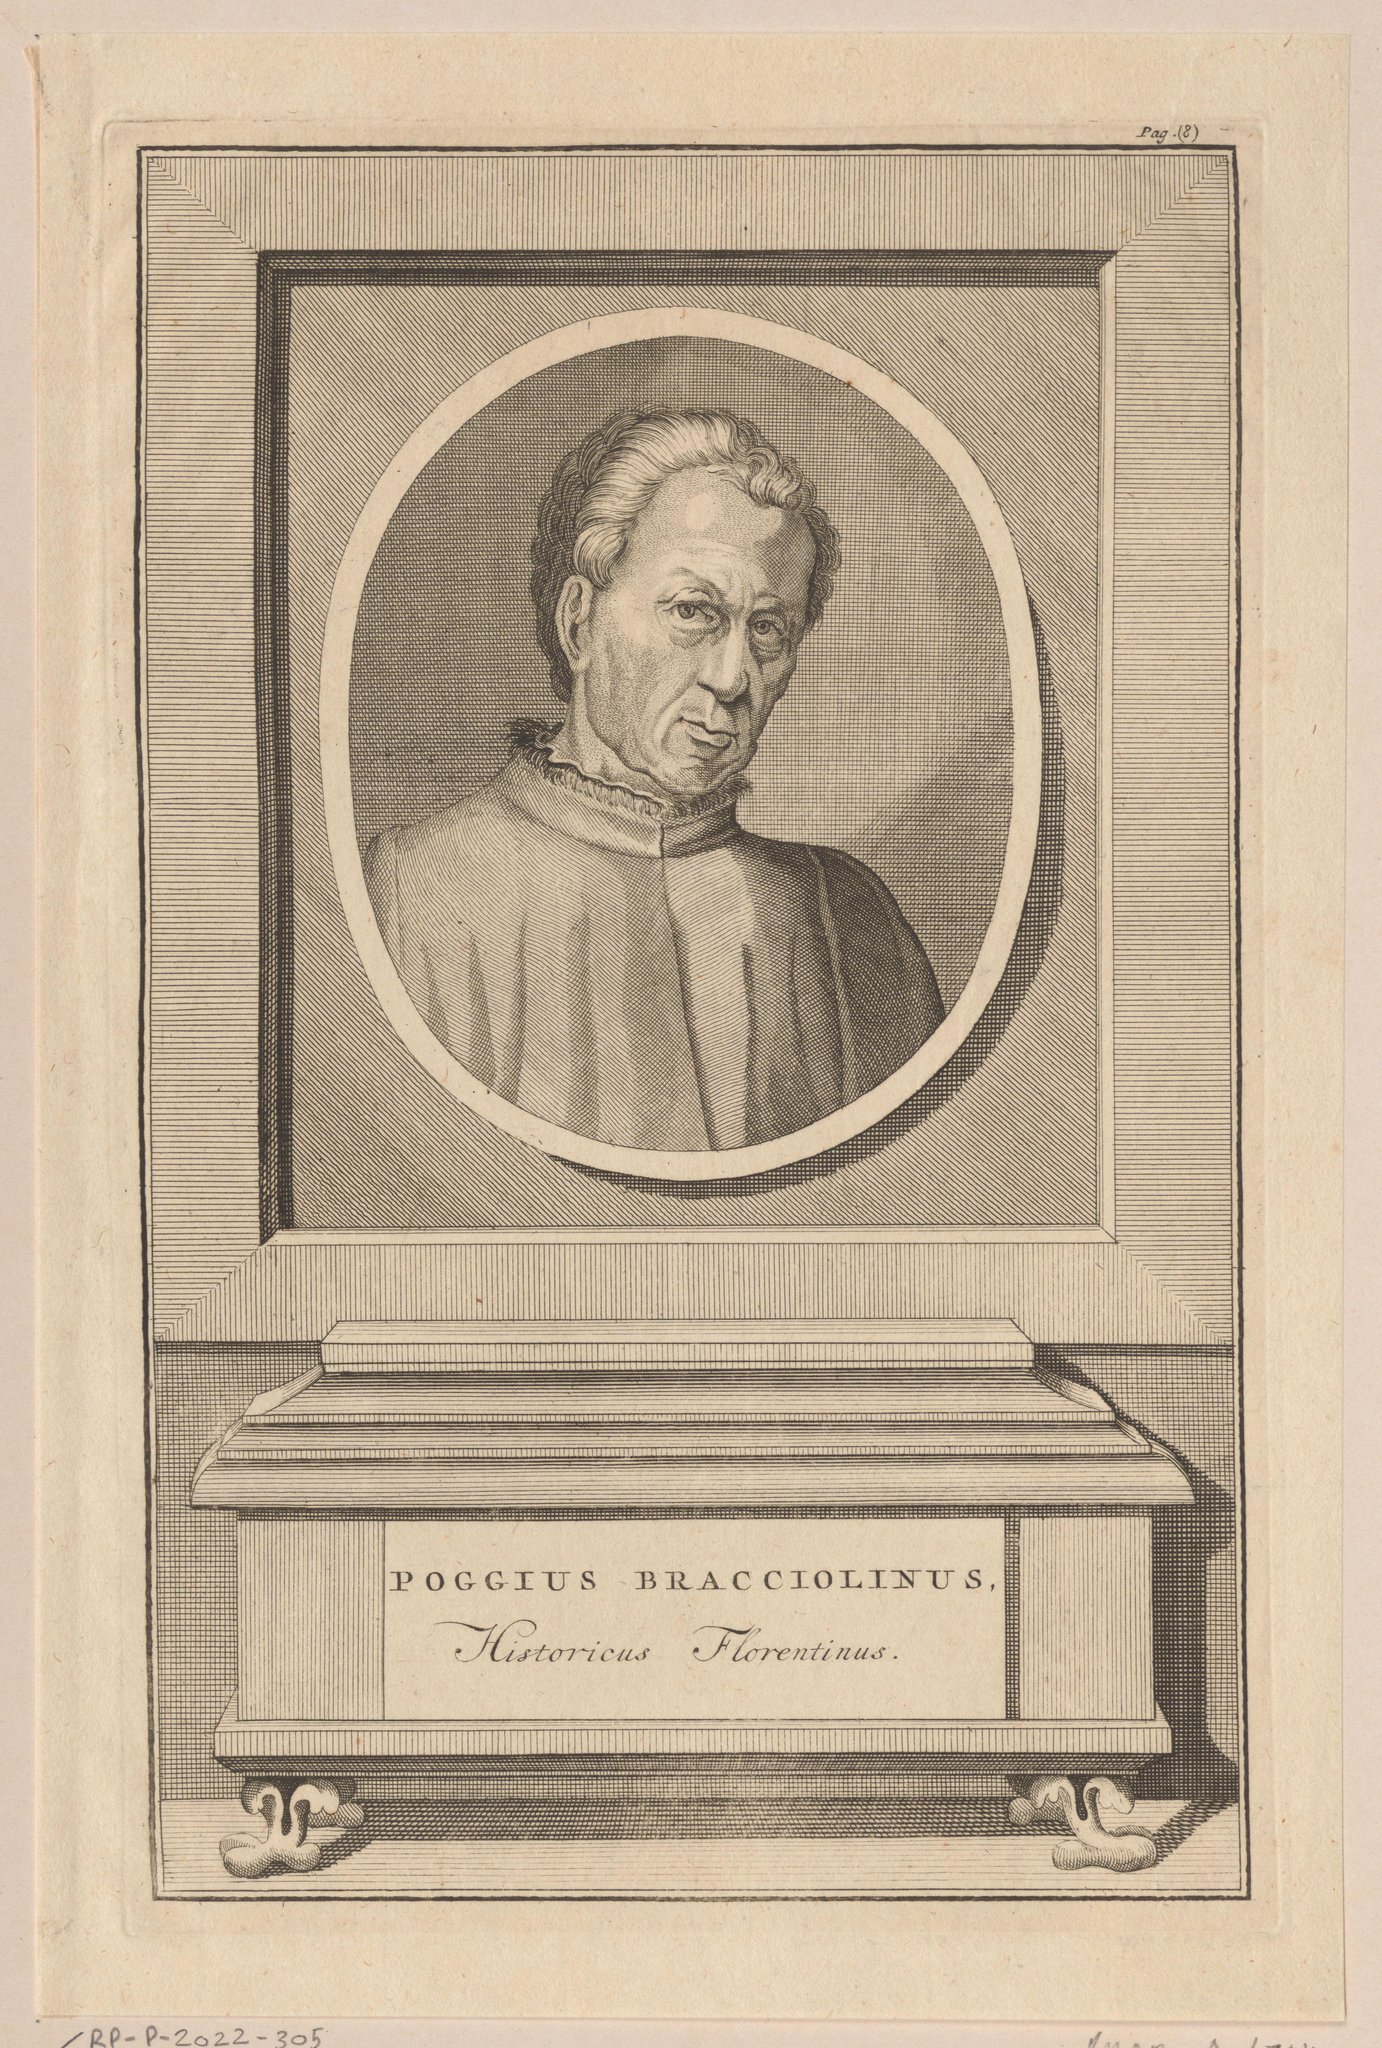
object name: print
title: Portret van Gian Francesco Poggio Bracciolini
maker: Anonymous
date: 1723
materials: paper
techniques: etching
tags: scholar, philosopher, historical persons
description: Prent waarschijnlijk uit: Graevius, Johann Georg. Thesaurus antiquitatum et historiarum Italiae (...). Leiden: Pieter van der Aa I, 1723, dl. 8.1.